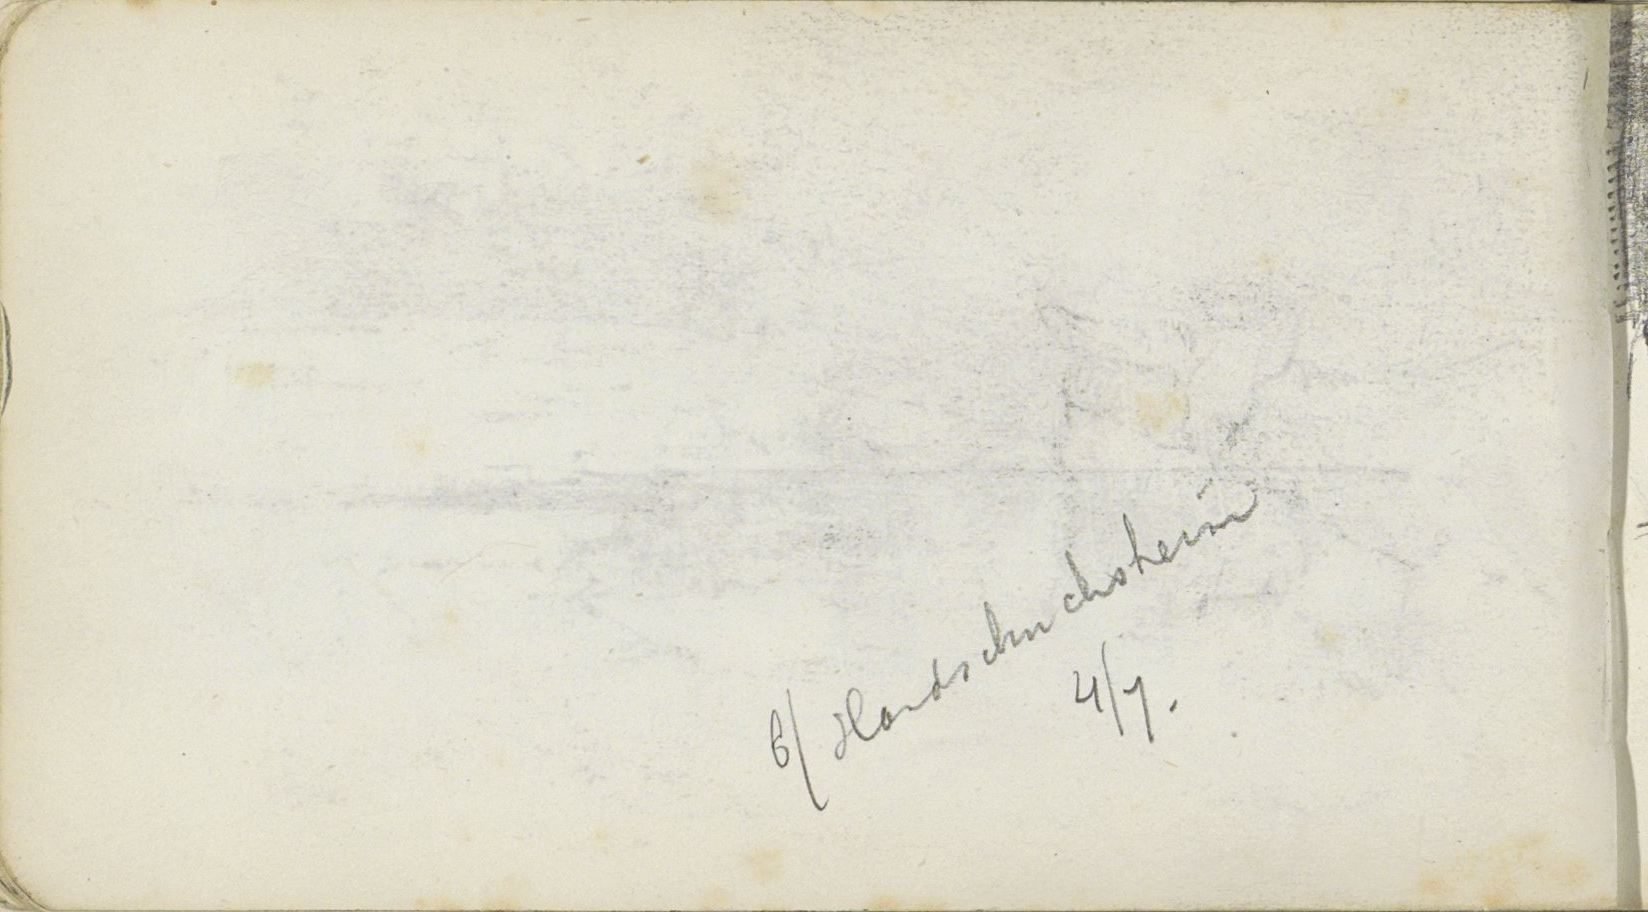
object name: sketchbook leaf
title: Notitie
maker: geo poggenbeek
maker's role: draughtsman, painter, print maker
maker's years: 1853-1903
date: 1807-1876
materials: paper, pencil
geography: handschuhsheim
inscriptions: date and inscription: ‘6/ Handschu chsheim/ 4/7’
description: Blad 18 verso uit een schetsboek met 69 bladen.